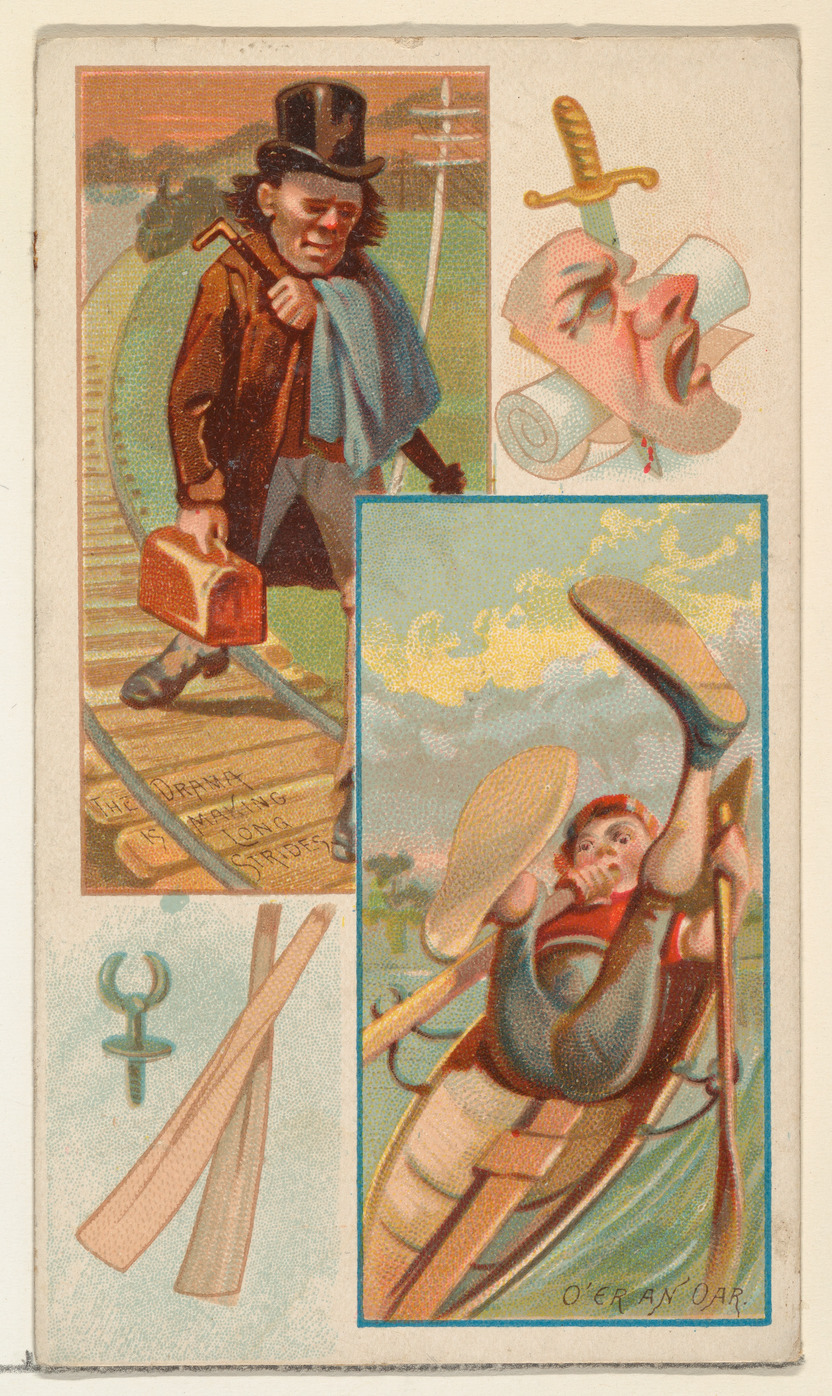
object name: print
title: The Drama is Making Long Strides / O'er an Oar, from the Jokes series (N118) issued by Duke Sons & Co. to promote Honest Long Cut Tobacco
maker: w. duke, sons & co.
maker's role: publisher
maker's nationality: american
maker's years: 1870-1920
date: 1891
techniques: color lithograph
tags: men,boats